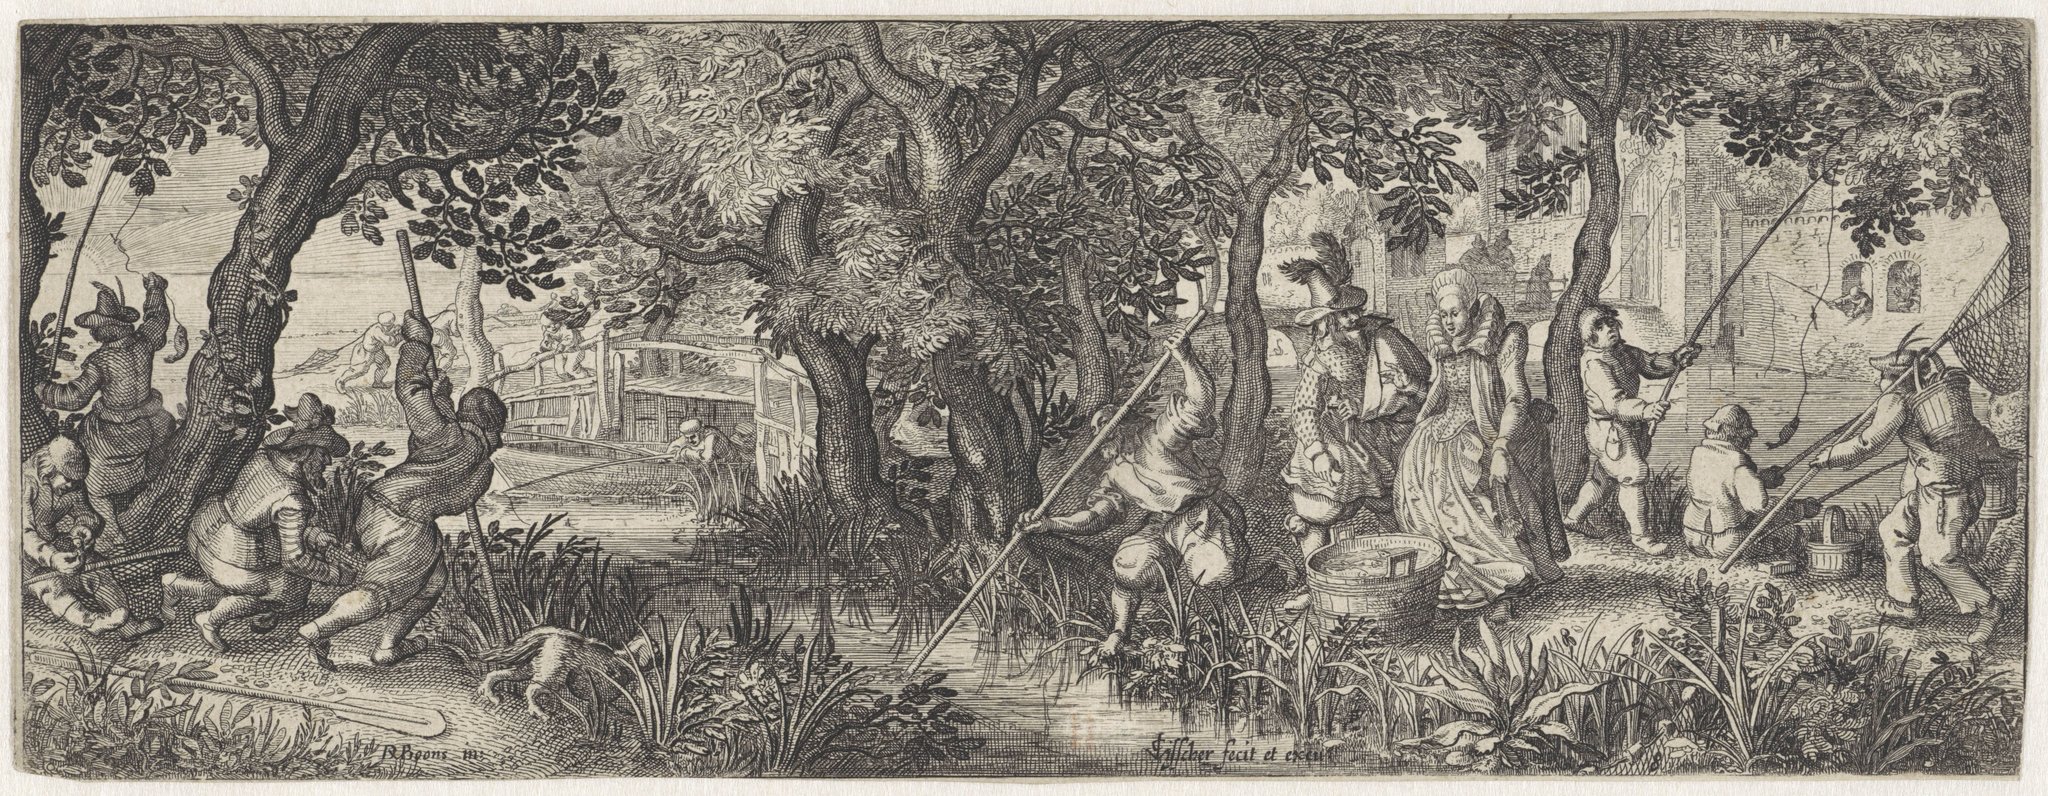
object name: print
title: Jachttaferelen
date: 1612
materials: paper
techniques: engraving, etching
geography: amsterdam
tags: fresh-water fishery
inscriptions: collector's mark: Lugt 240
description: Een rijk geklede dame kijkt in het gezelschap van een heer naar vissen die in een tobbe zwemmen. Om hen heen worden in een beek en in de gracht van het kasteel op de achtergrond nog meer vissen gevangen met hengels en netten. Ook vanuit een raam in het kasteel wordt een hengeltje uitgeworpen.